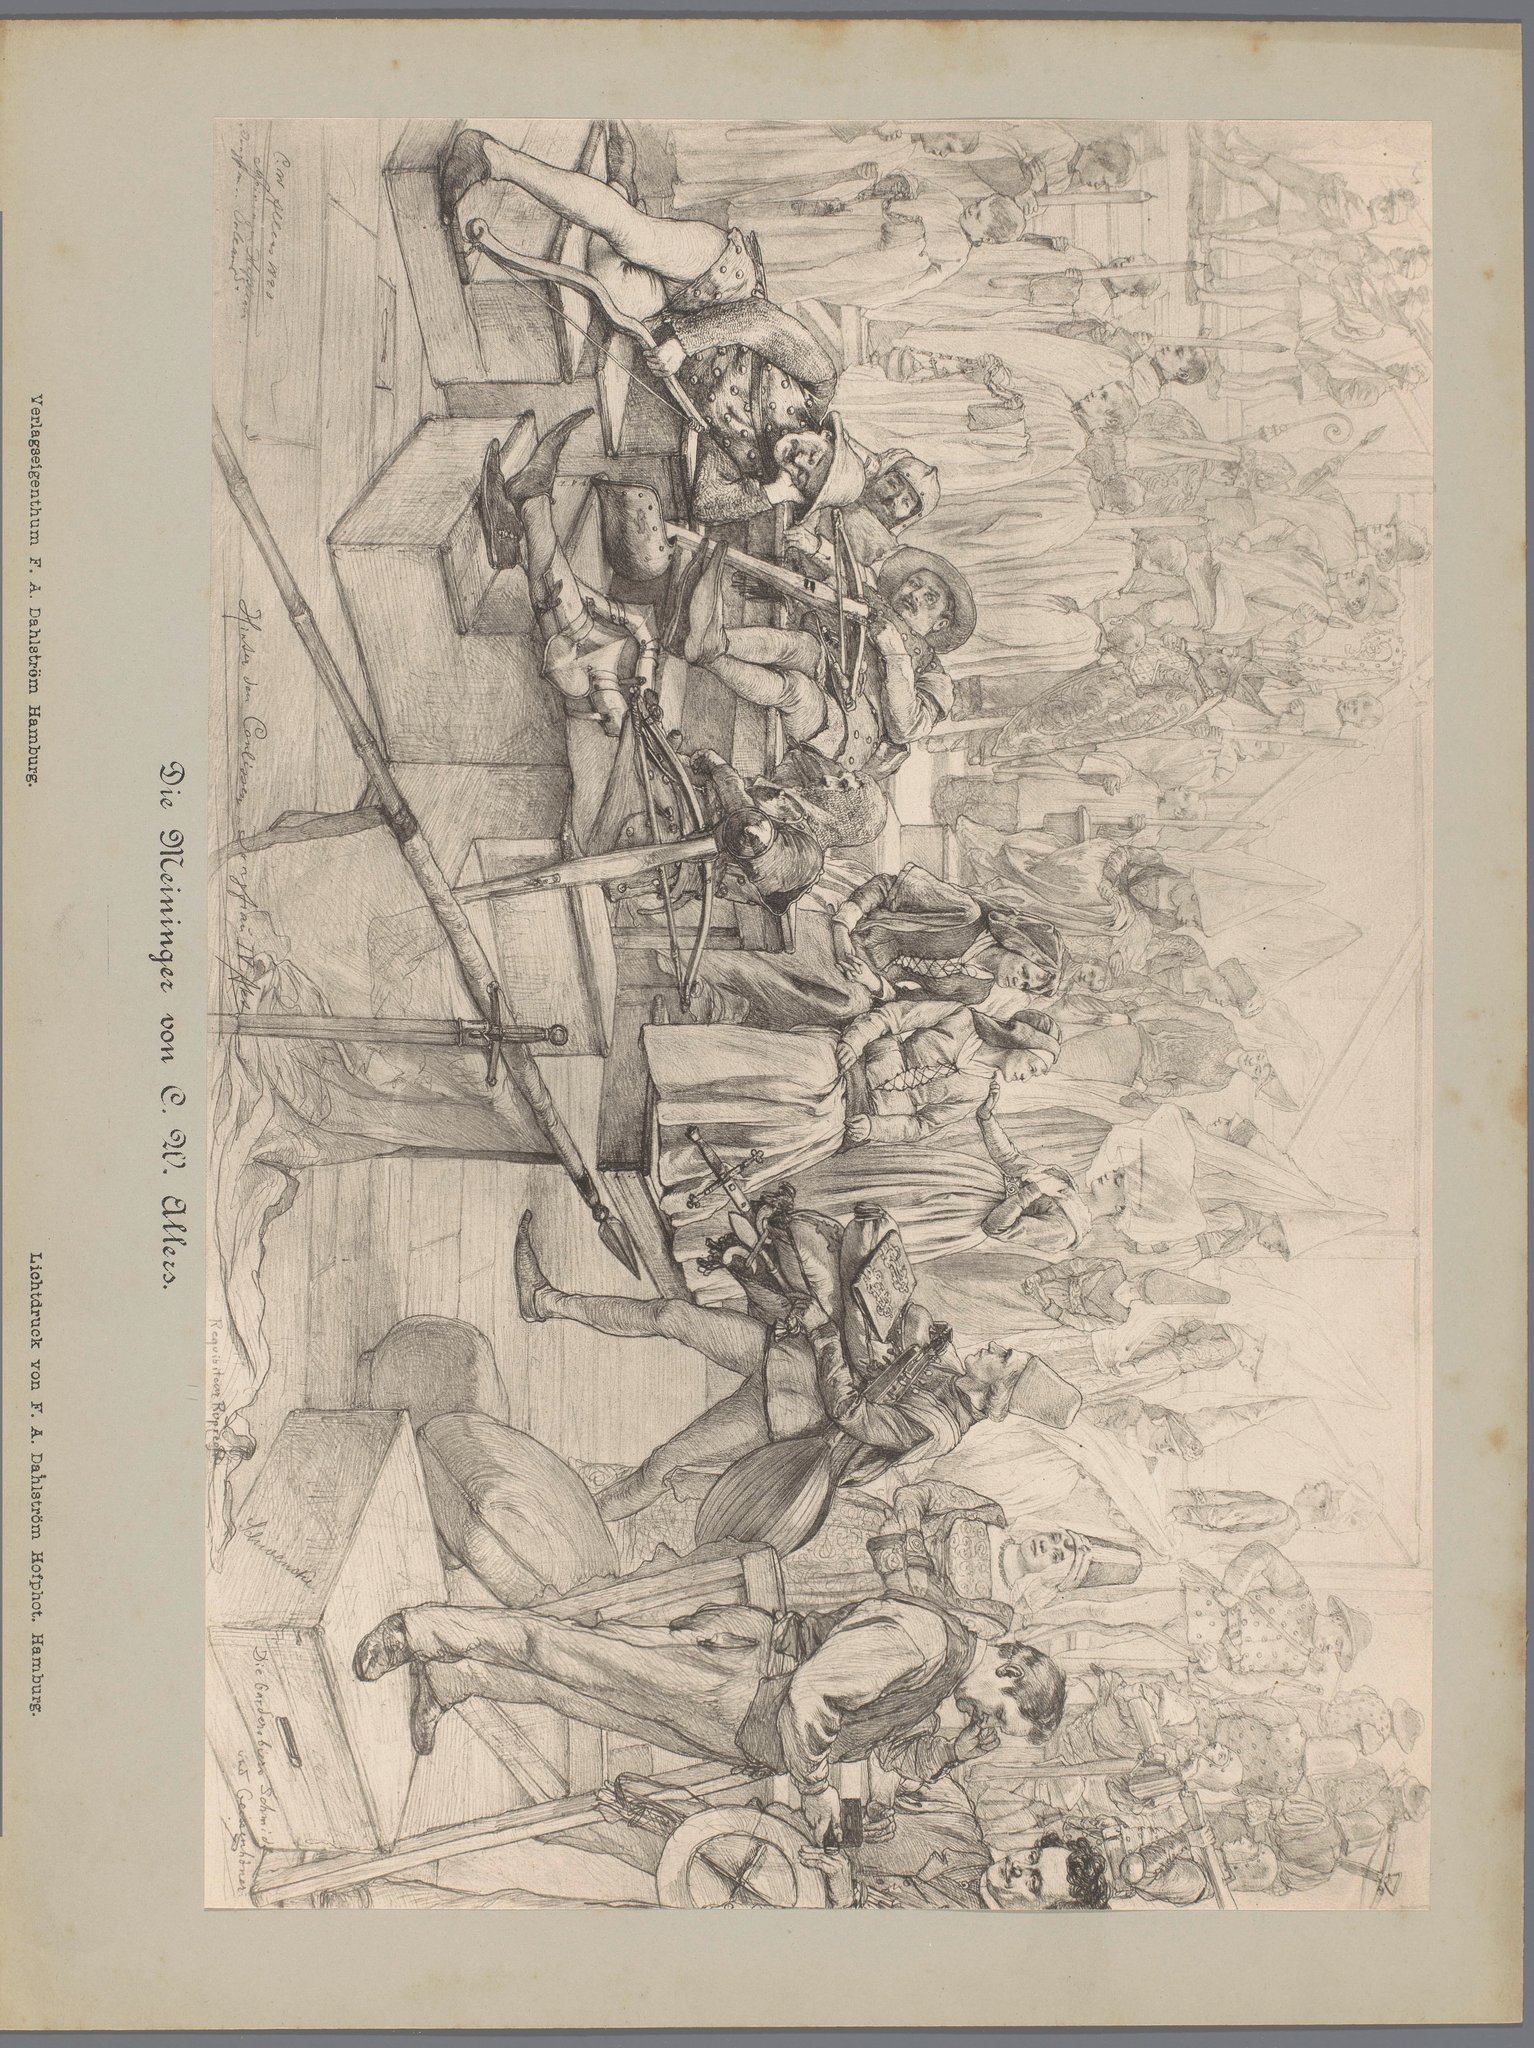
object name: page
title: Fotoreproductie van een tekening, voorstellende acteurs achter de schermen bij een opvoering van de Maagd van Orleans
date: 1890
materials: paper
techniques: photograph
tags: group of actors, troupe; actors on the stage, rehearsal, studying the role ~ theatre